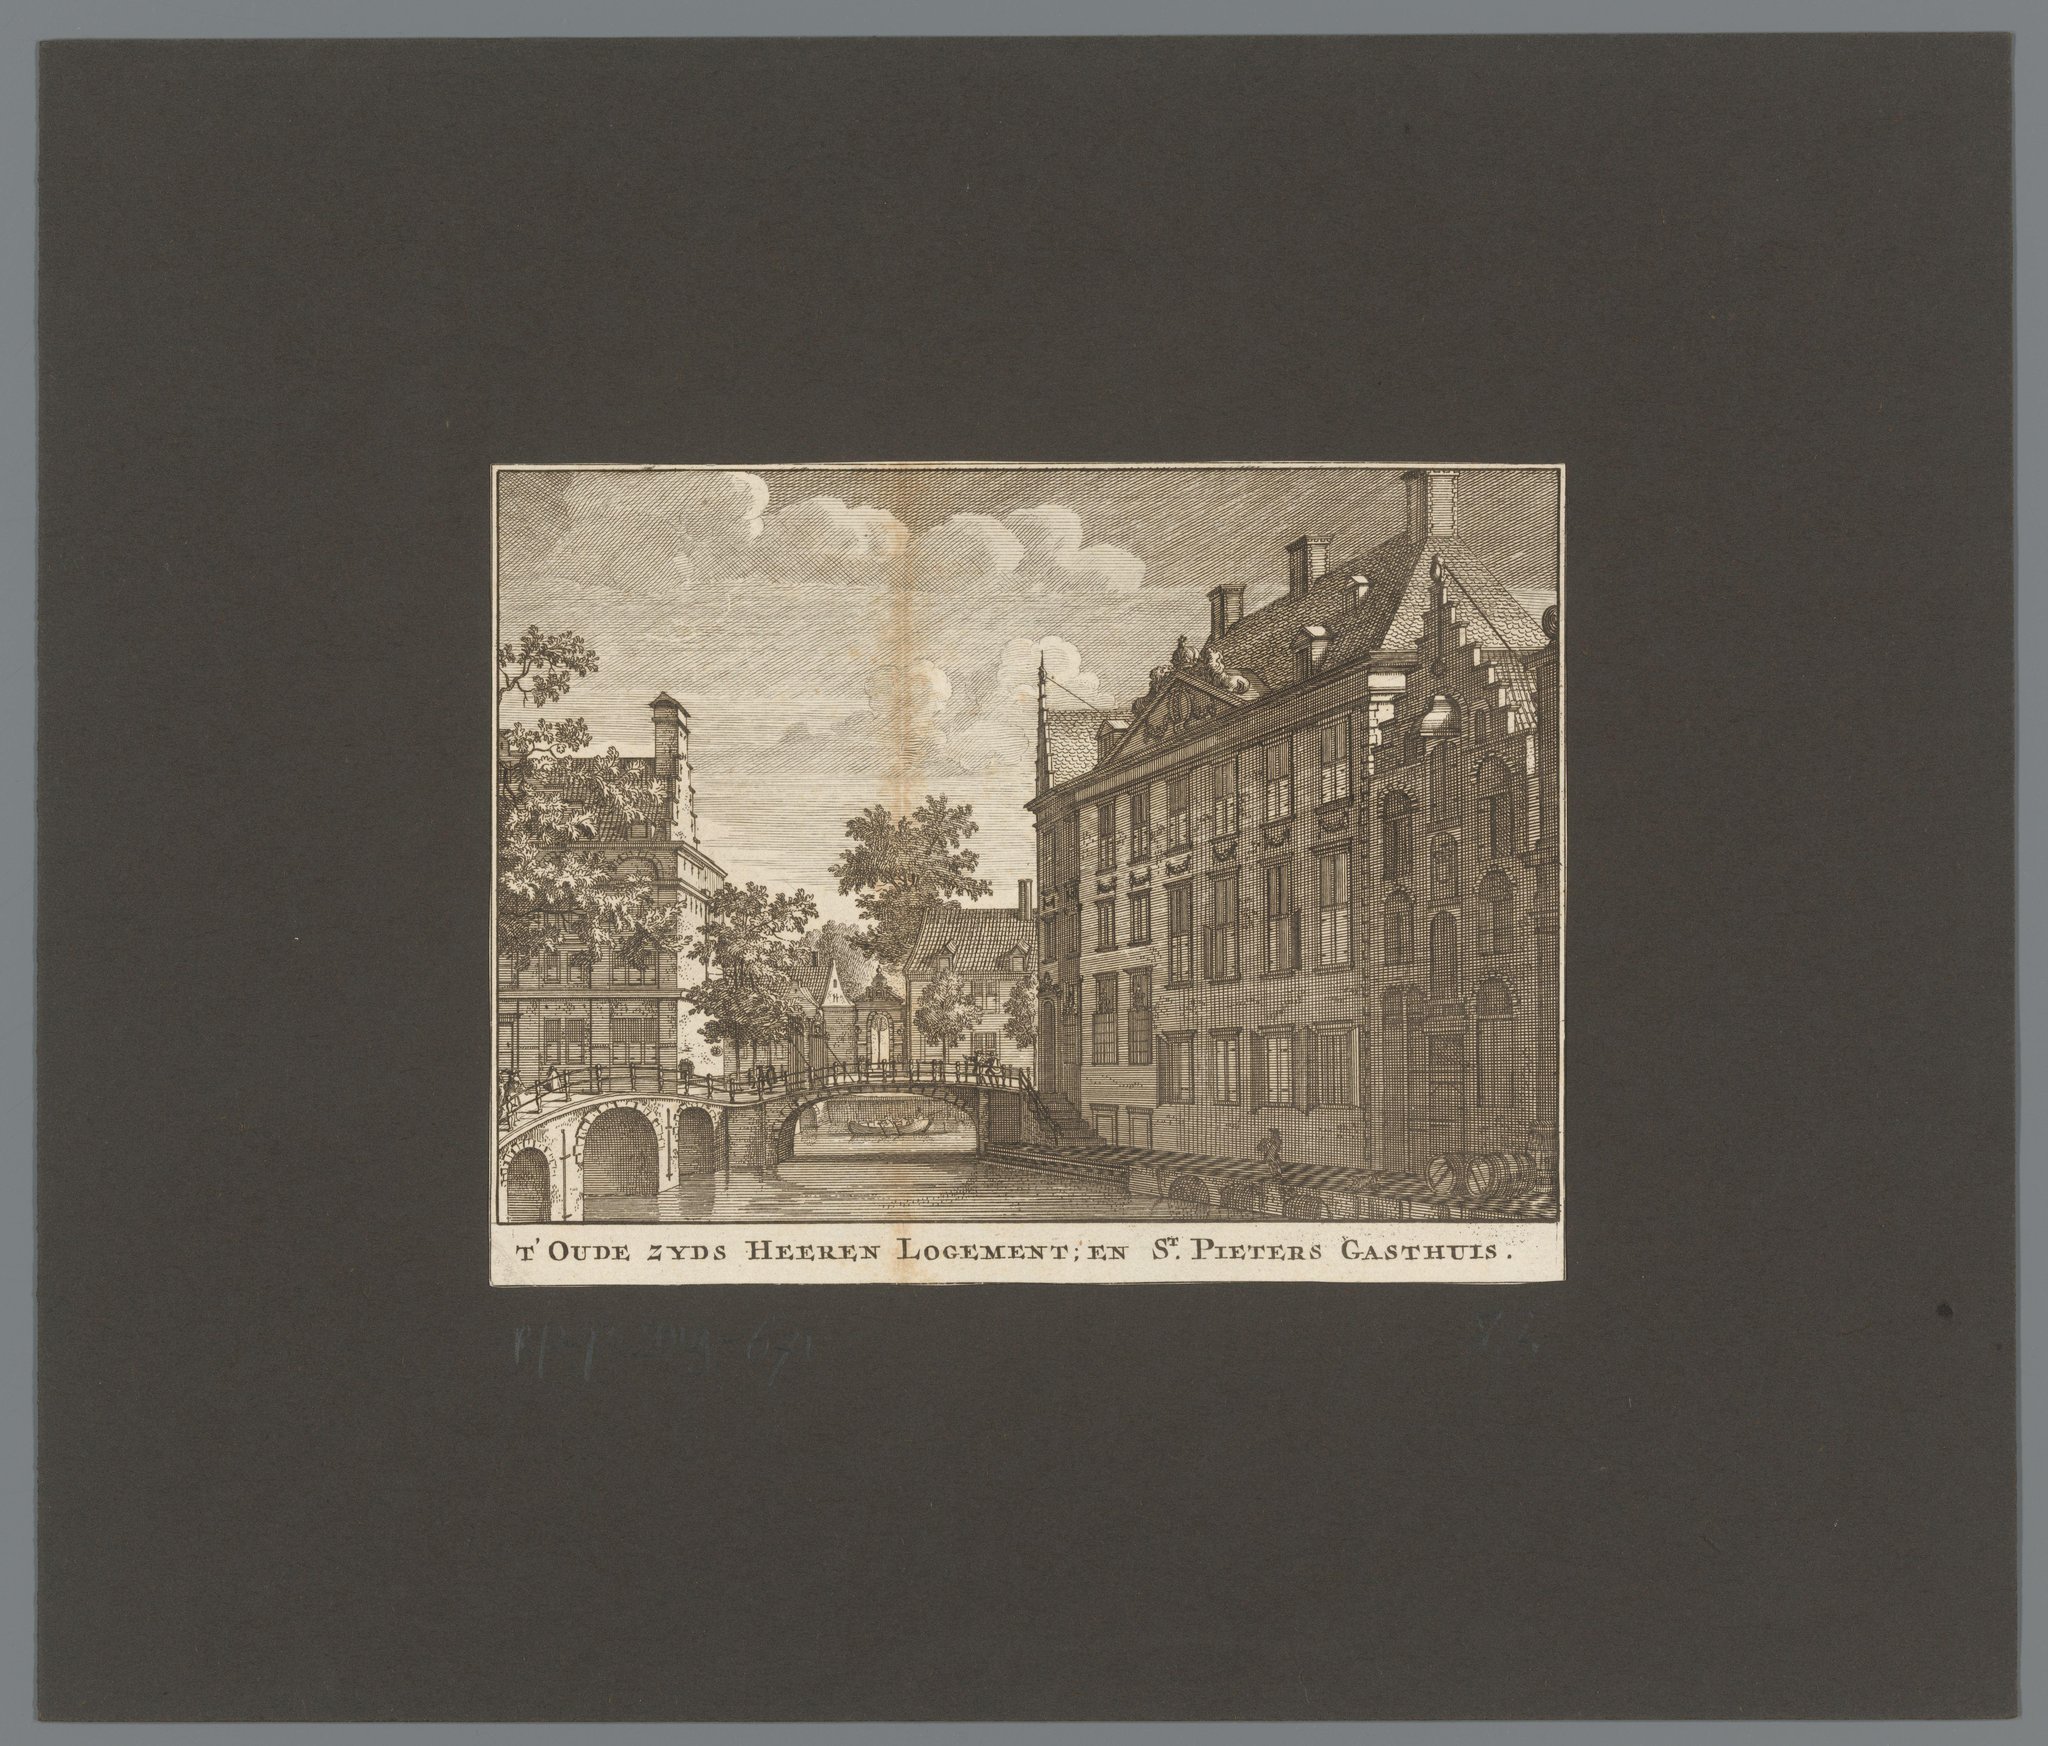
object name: book illustration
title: Gezicht op het Oudezijds Heerenlogement en Binnengasthuis in Amsterdam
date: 1713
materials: paper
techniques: etching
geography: amsterdam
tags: bridge in city across river, canal, etc., hotel, hostelry, inn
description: Prent uit: Hoorn, Nicolaas ten. Wegwijzer door Amsterdam, zijnde eene beknopte verhandeling van desselfs eerste opkomst, vergrootingen, en teegenwoordigen staat (...). Amsterdam: Nicolaas ten Hoorn, 1713, tussen p. 342 en p. 343.